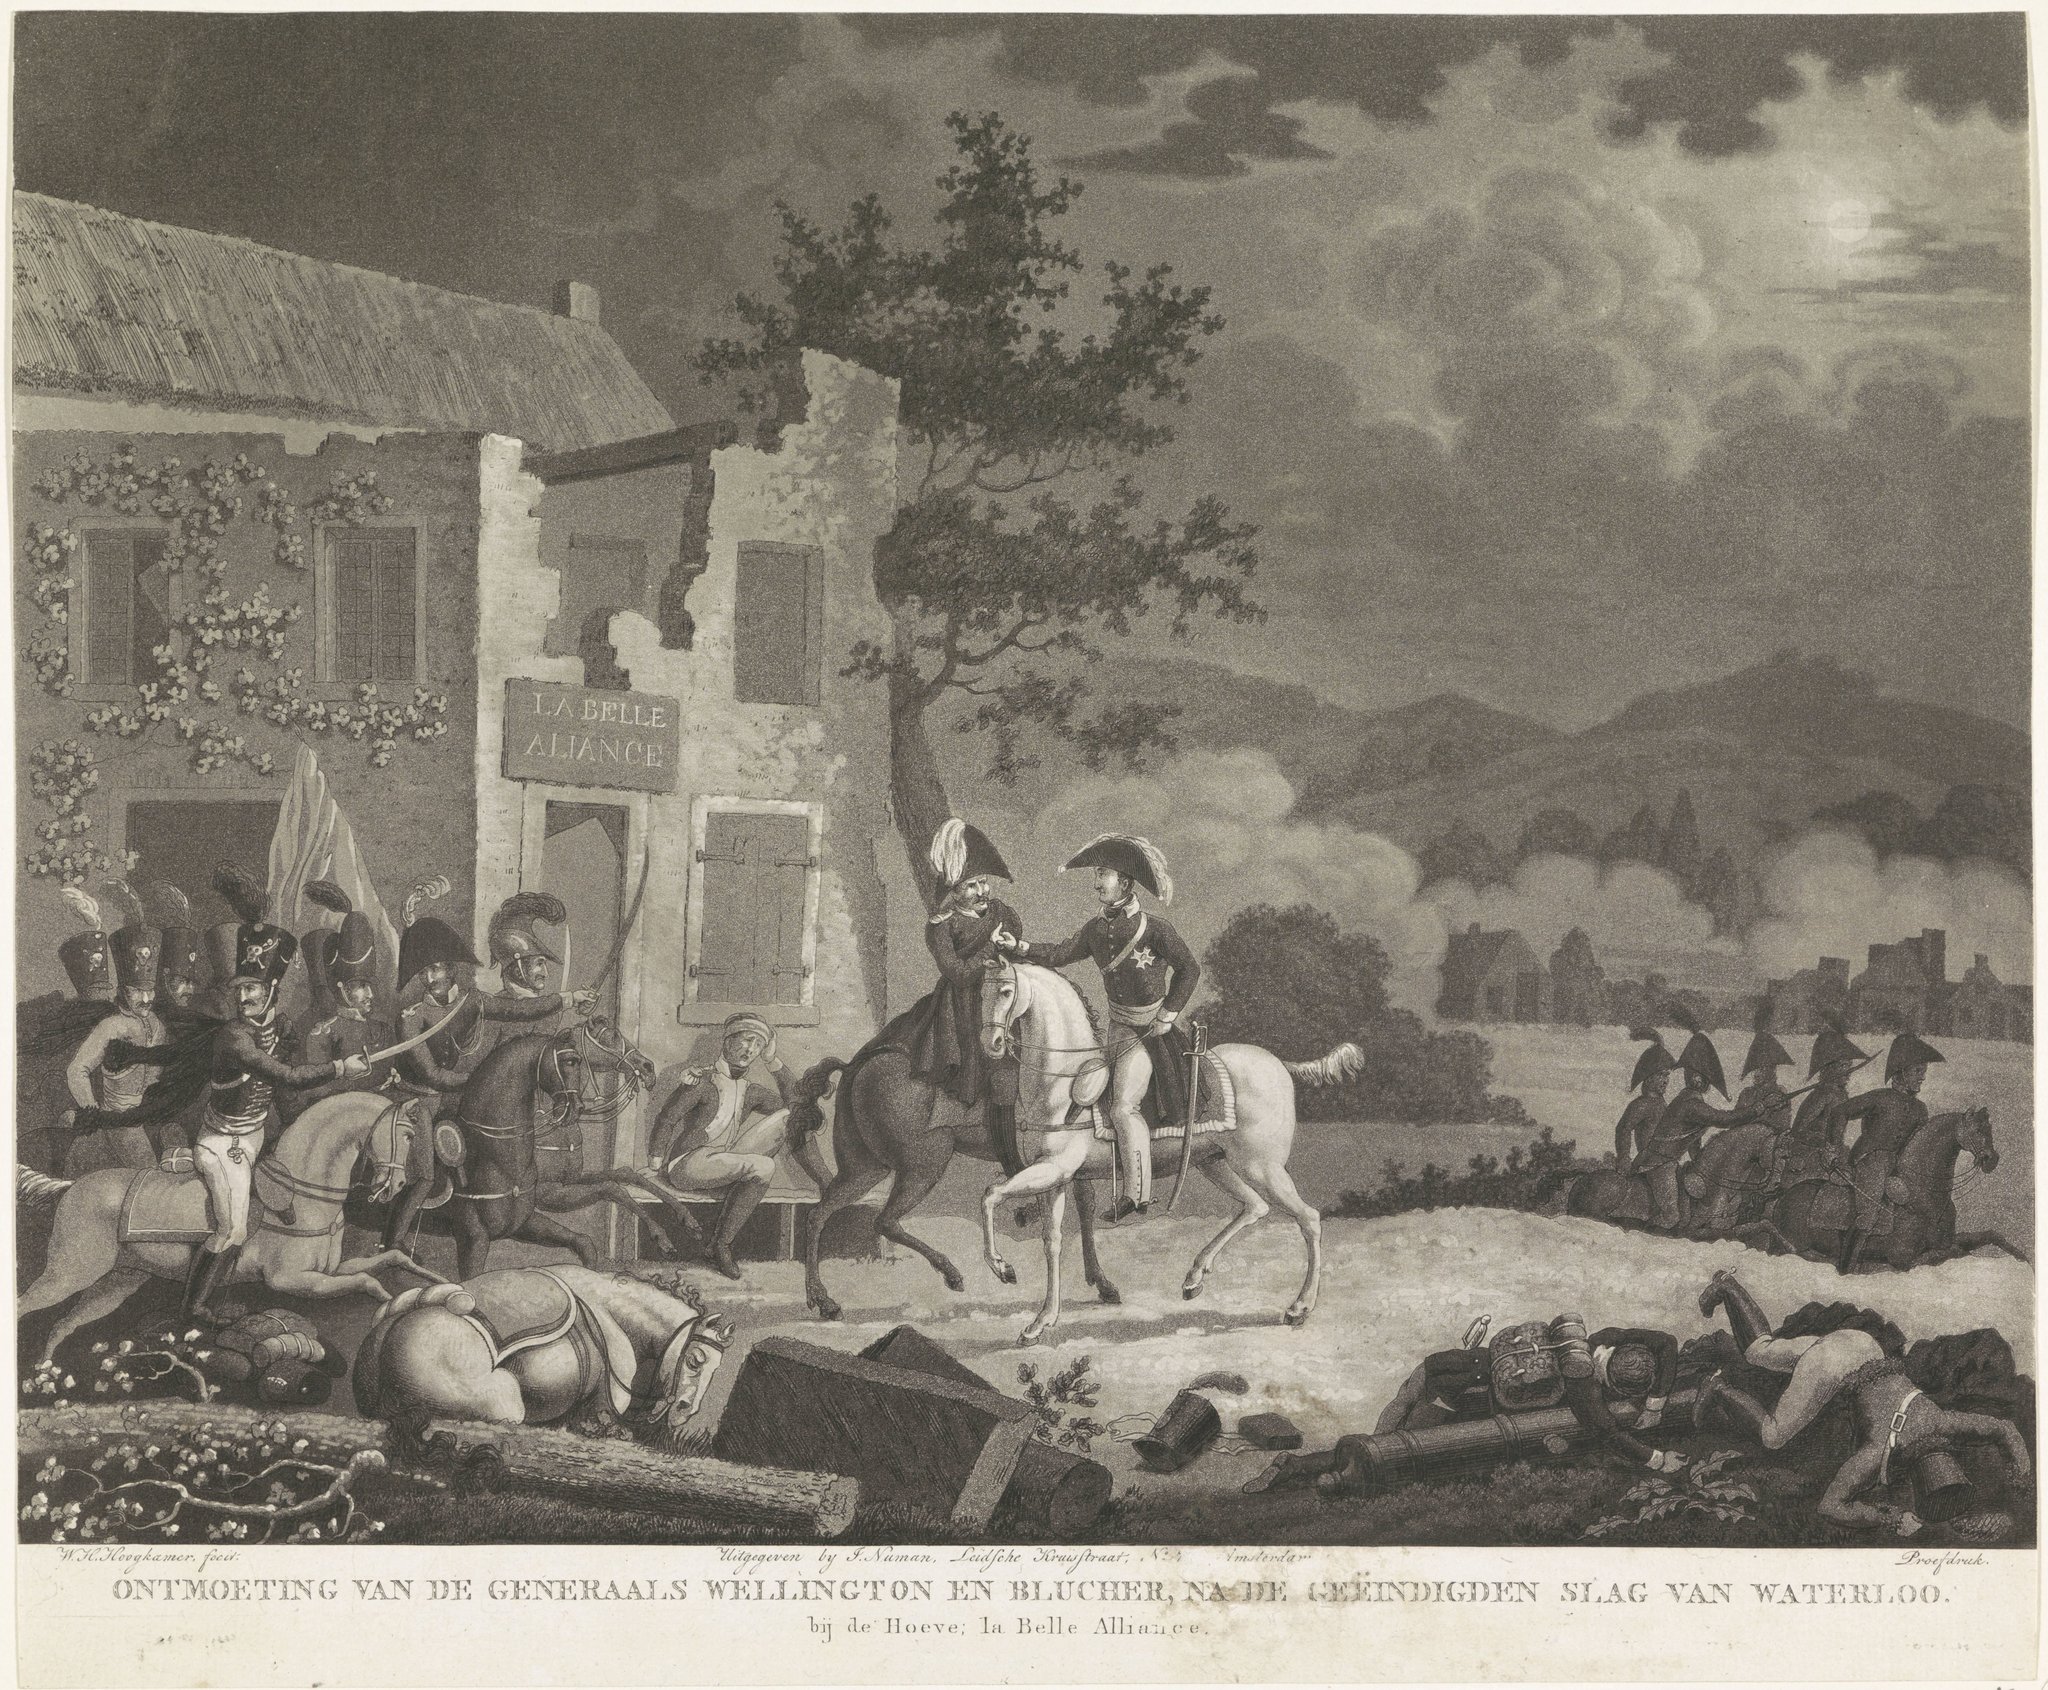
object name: print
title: Ontmoeting van de generaals Wellington en Blucher, na de geëindigden slag van Waterloo. bij de Hoeve; la Belle Alliance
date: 1815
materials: paper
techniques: aquatint, etching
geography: netherlands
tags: walmer castle, arthur wellesley of wellington, victor (after the battle)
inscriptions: collector's mark: Lugt 2228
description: Ontmoeting tussen de opperbevelhebbers de hertog van Wellington en de vorst Blücher, 's avonds na de slag bij Waterloo op 18 juni 1815, voor de boerderij La Belle Alliance. Links Pruisische huzaren.